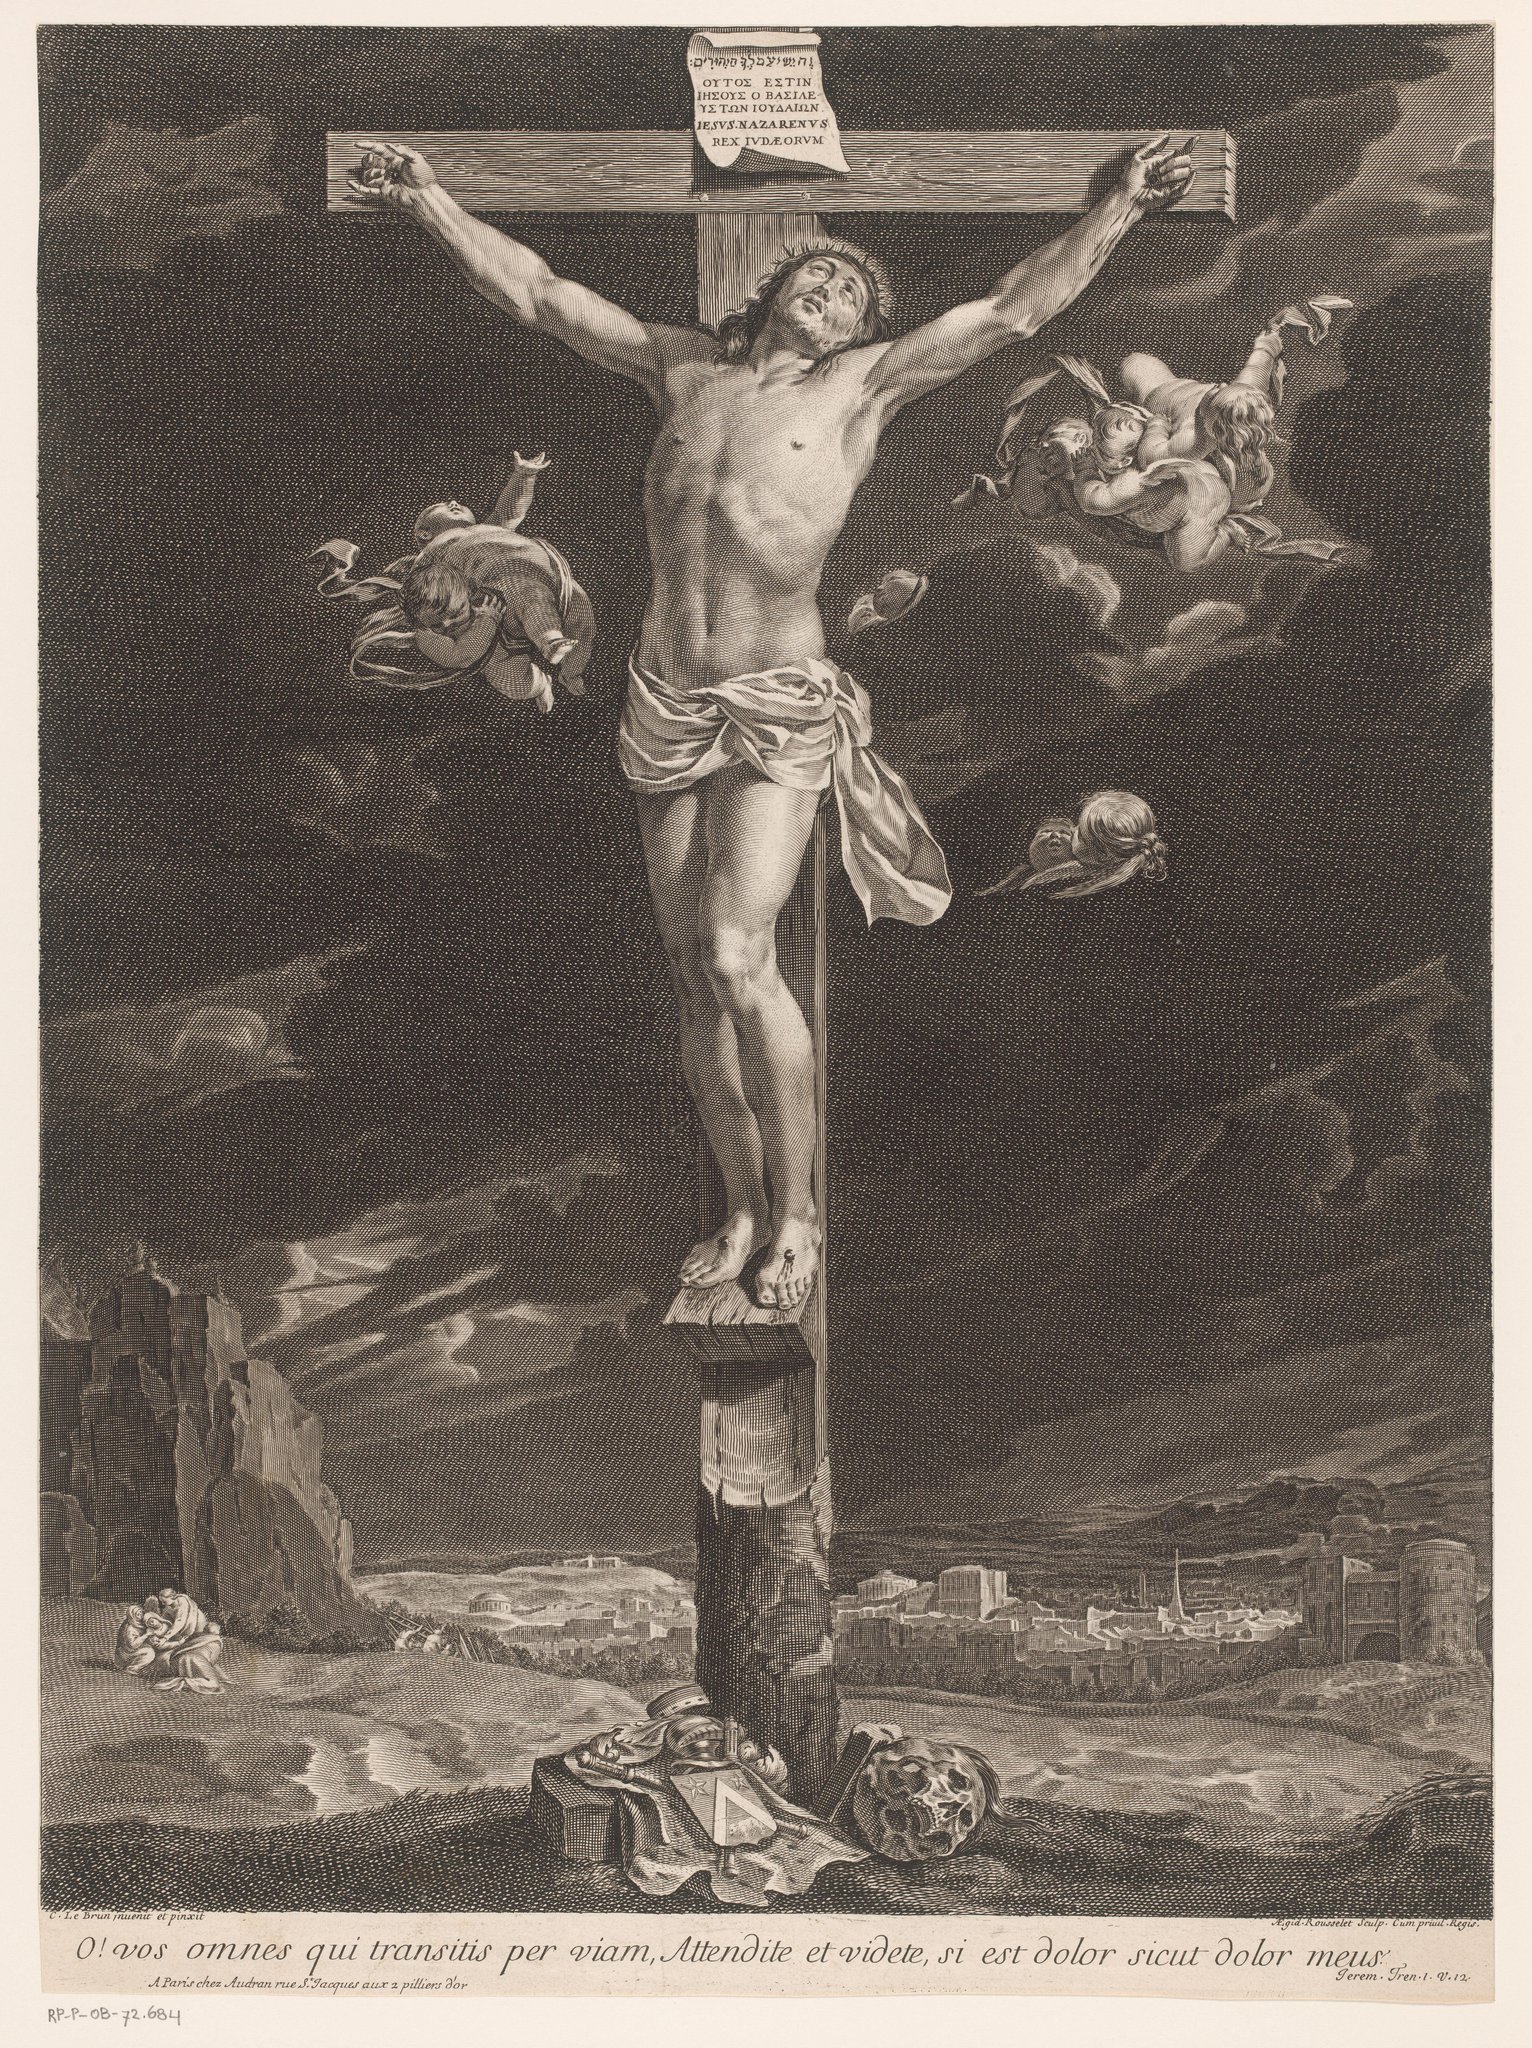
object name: print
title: Christus aan het kruis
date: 1648-1651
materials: paper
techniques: engraving, etching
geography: paris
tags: cupids: 'amores', 'amoretti', 'putti', the crucifixion of christ: christ's death on the cross; golgotha (matthew 27:45-58; mark 15:33-45; luke 23:44-52; john 19:25-38)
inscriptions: collector's mark: Lugt 240